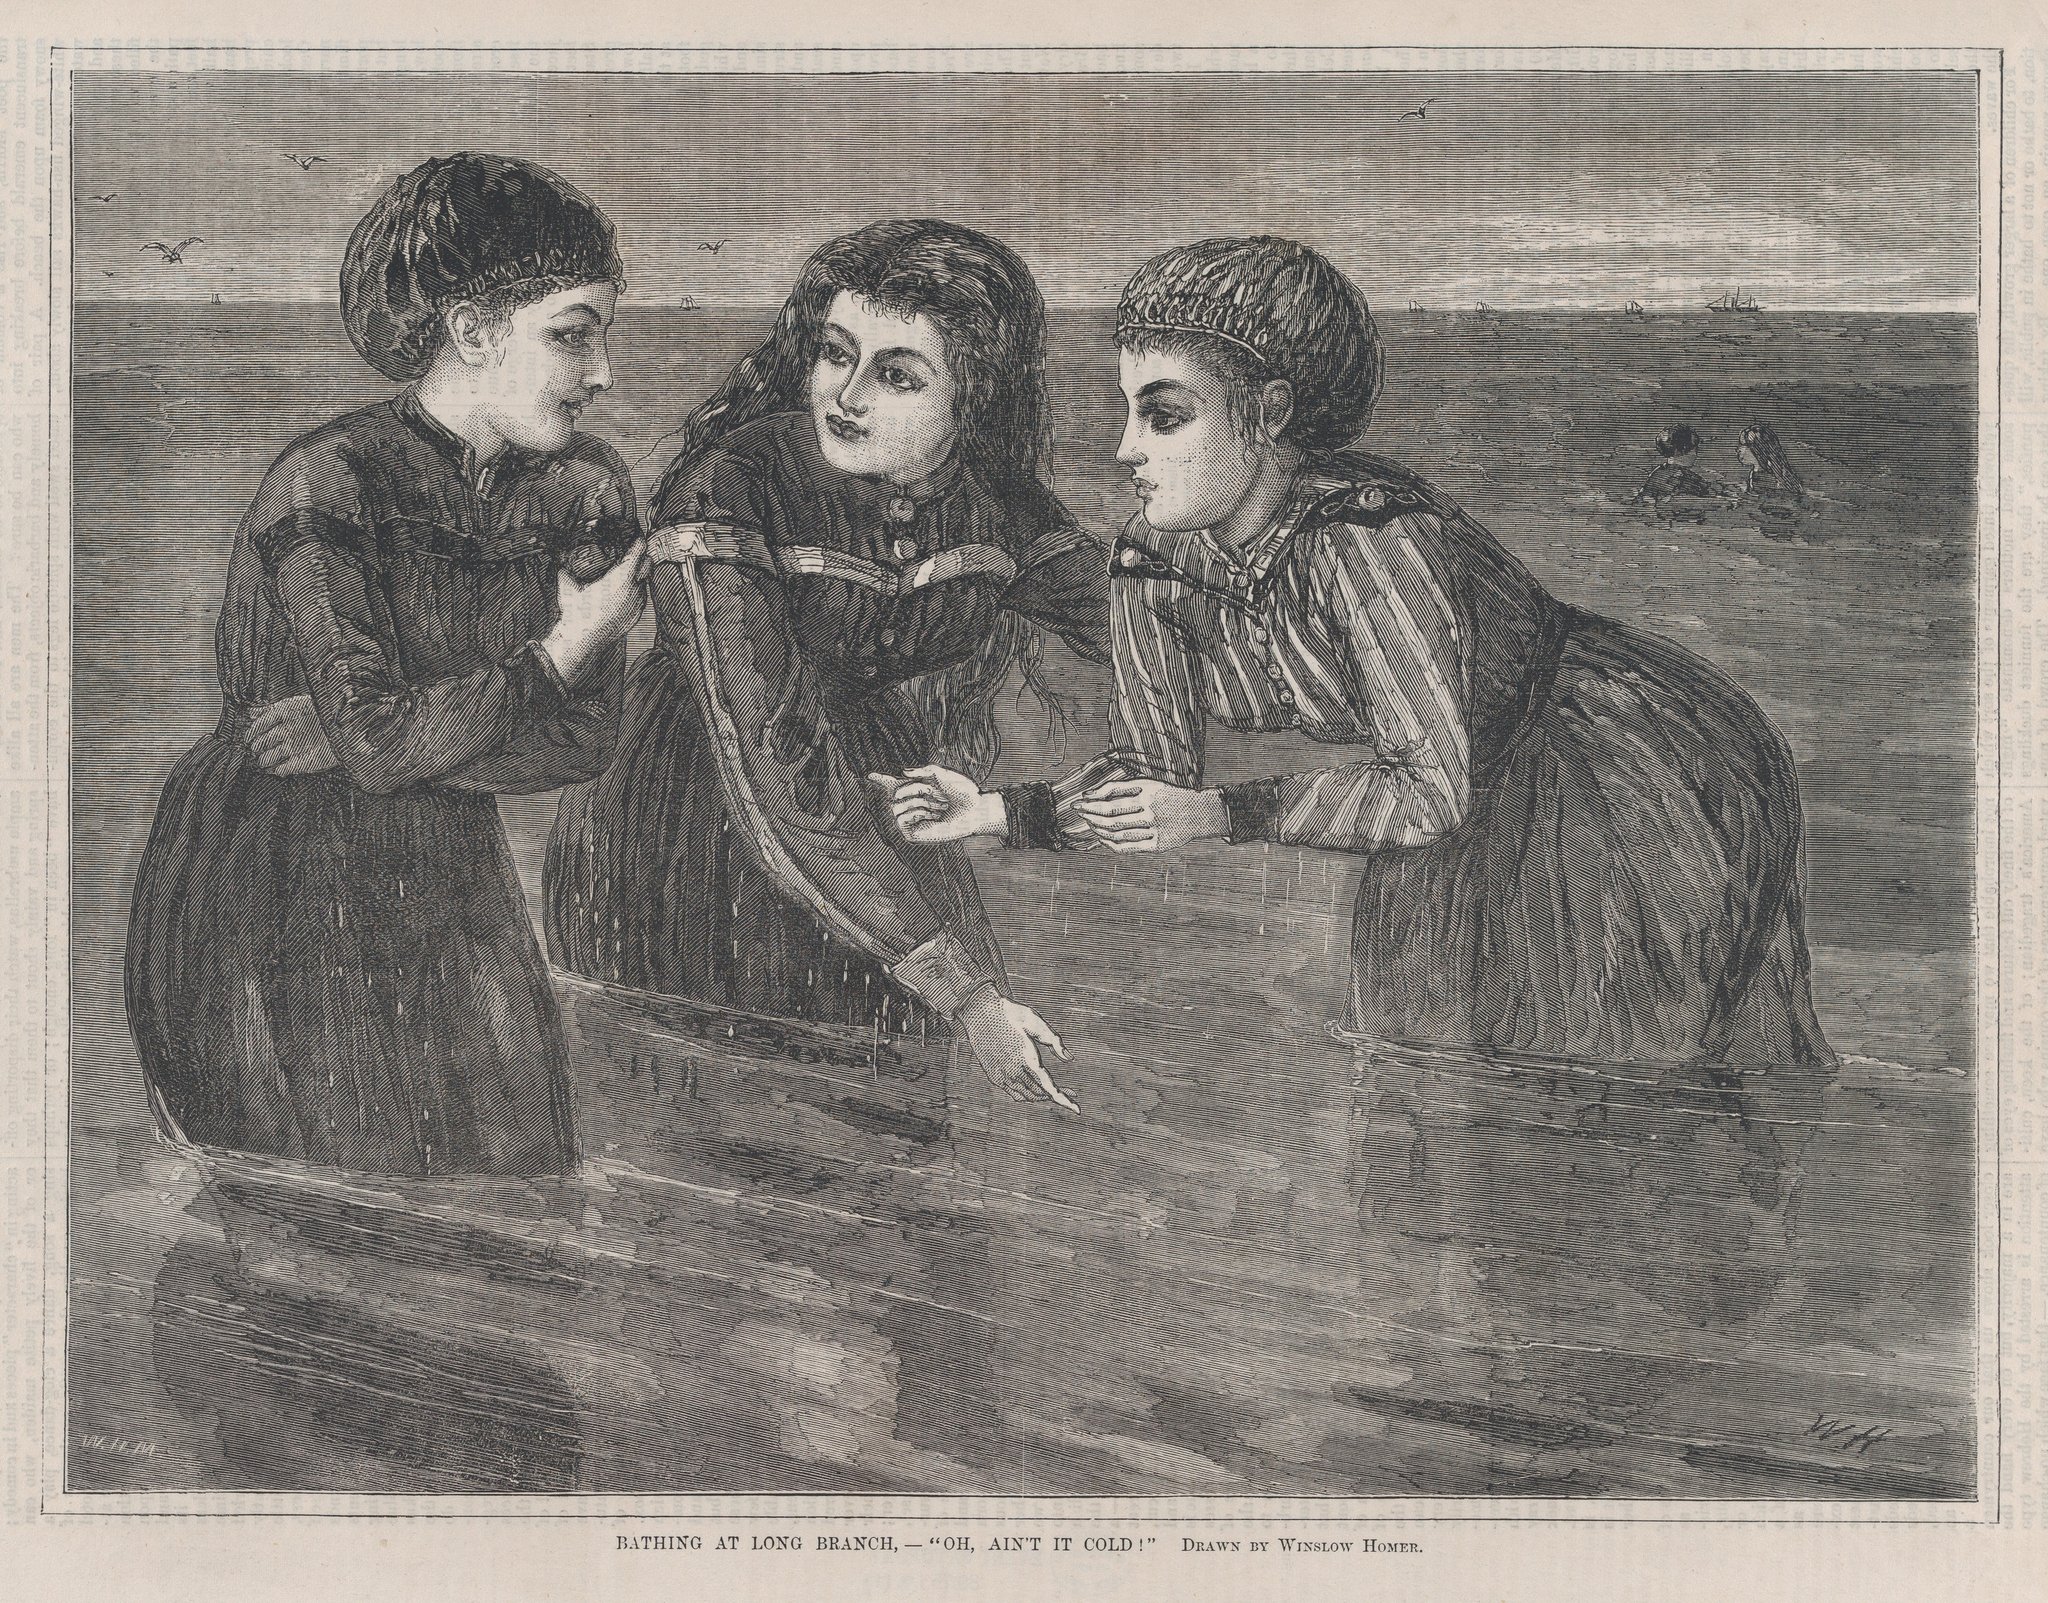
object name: print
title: Bathing at Long Branch "Oh, Ain't It Cold" (Every Saturday, Vol. III, New Series)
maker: winslow homer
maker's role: artist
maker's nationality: american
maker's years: 1836-1910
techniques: engraving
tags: women,bathing